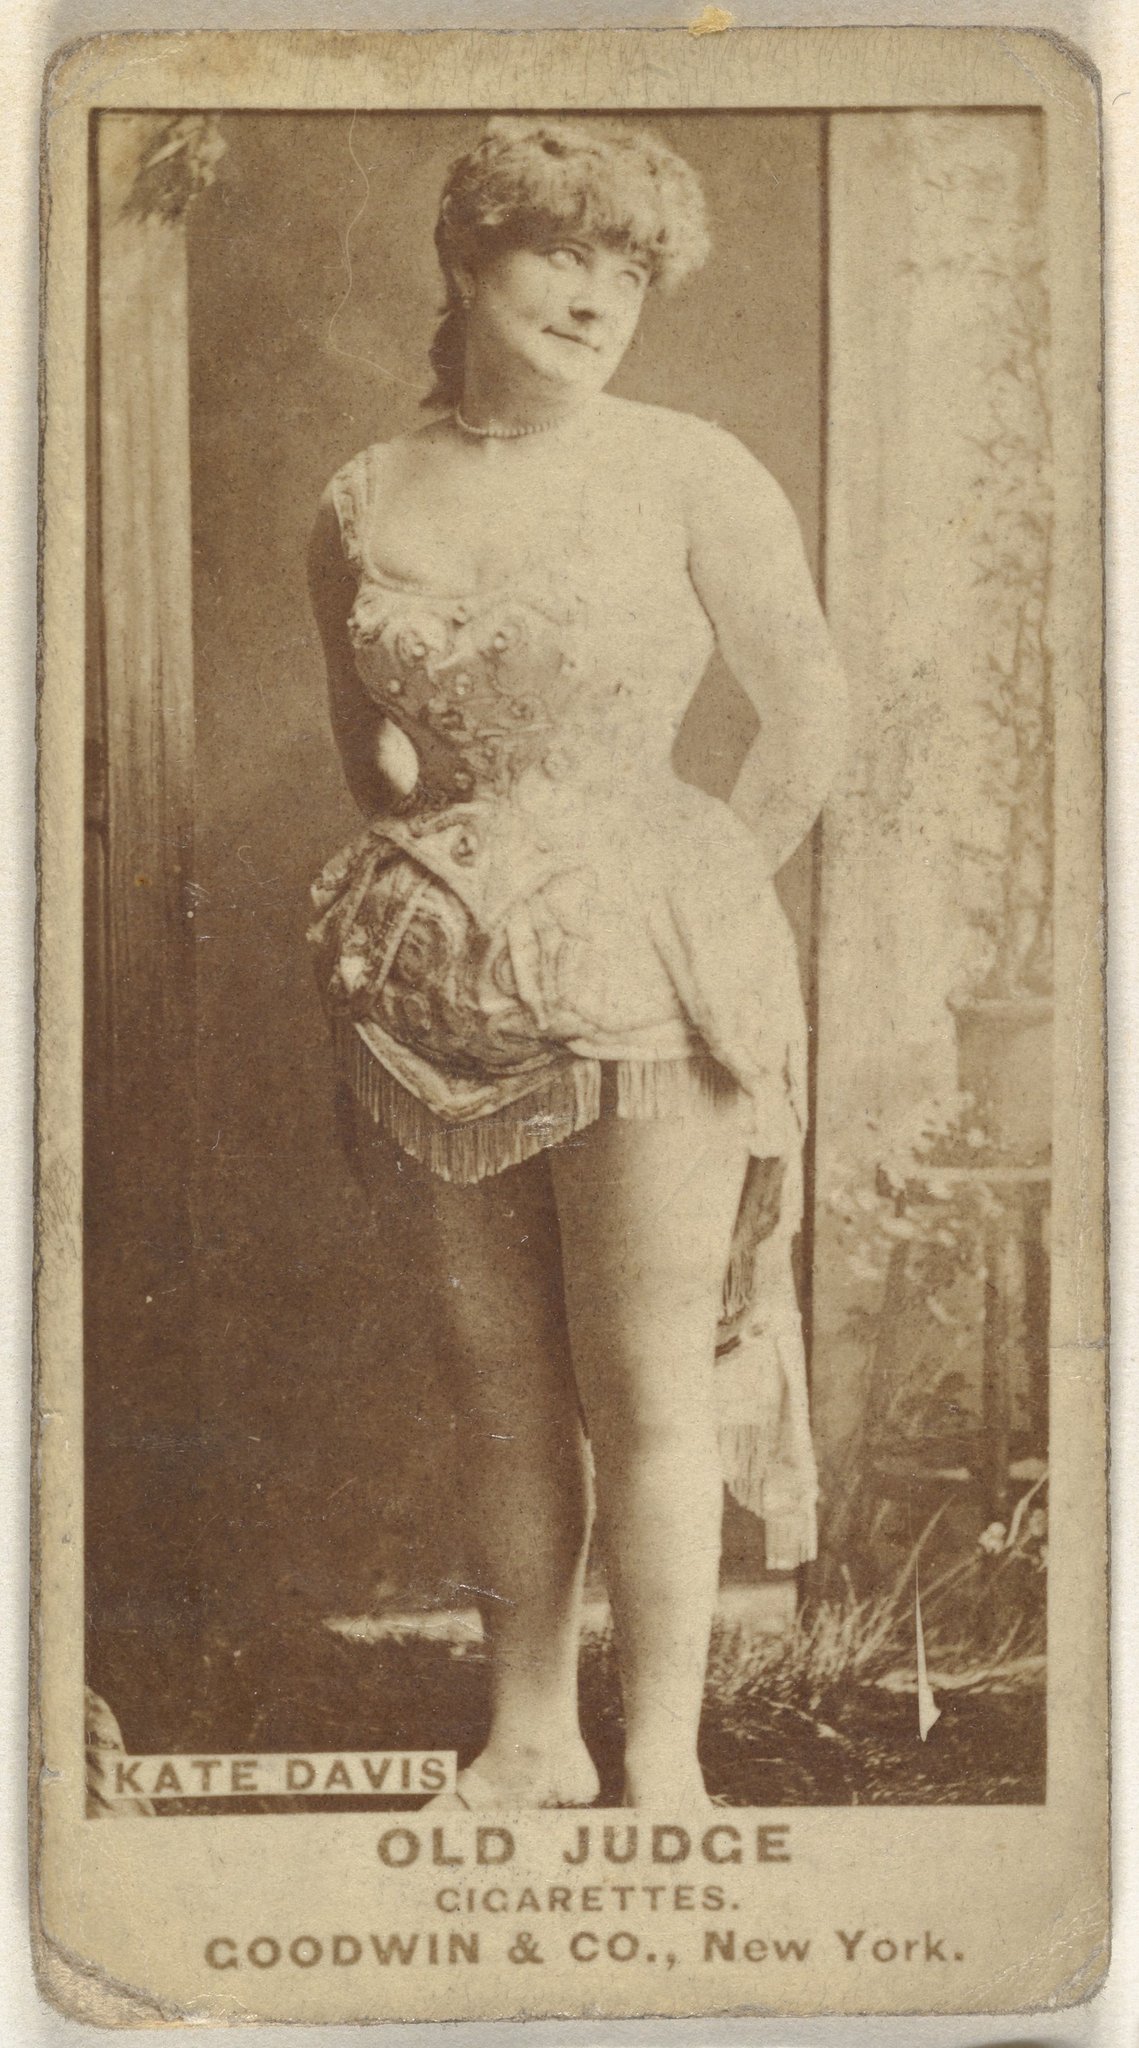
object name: photograph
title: Kate Davis, from the Actors and Actresses series (N171) for Old Judge Cigarettes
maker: goodwin & company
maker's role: publisher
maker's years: 1850-1950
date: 1886-1890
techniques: albumen silver print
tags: portraits,women,actresses